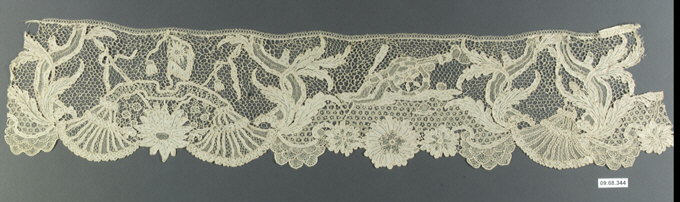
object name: fragment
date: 1701-1733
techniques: lace